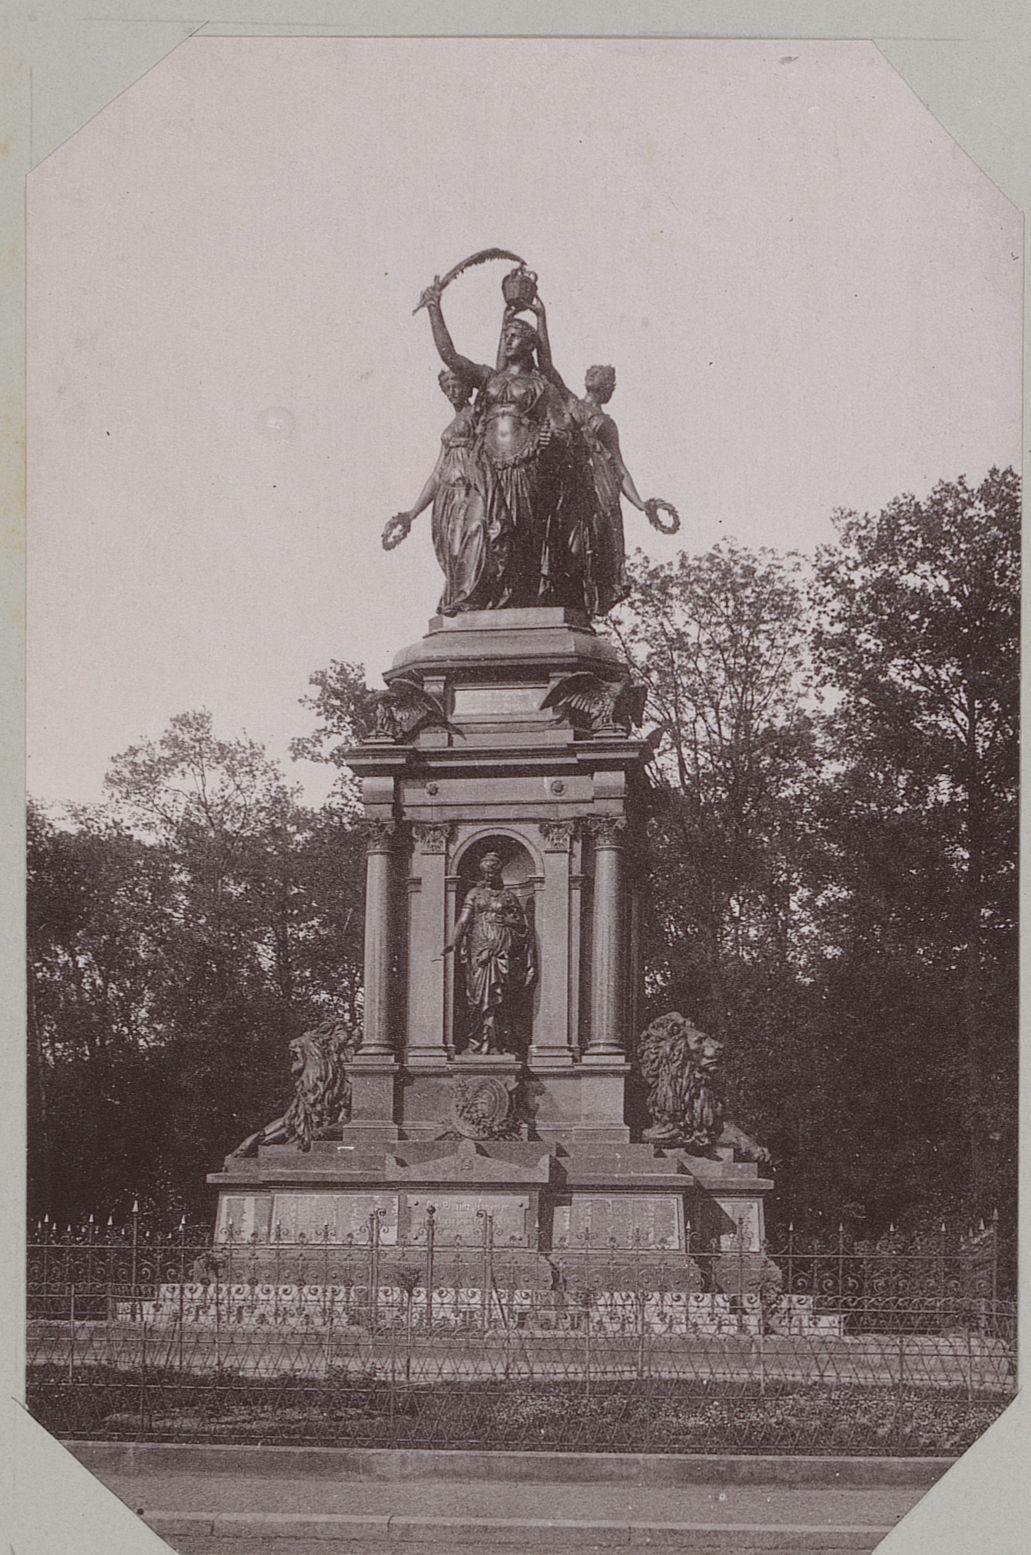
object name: album leaf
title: Oorlogsmonument in Hannover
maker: Anonymous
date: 1890-1897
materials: paper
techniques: photograph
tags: monument, statue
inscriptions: annotation: ‘Krigerdenkmal Hannover’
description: Deze prent maakt deel uit van een album.